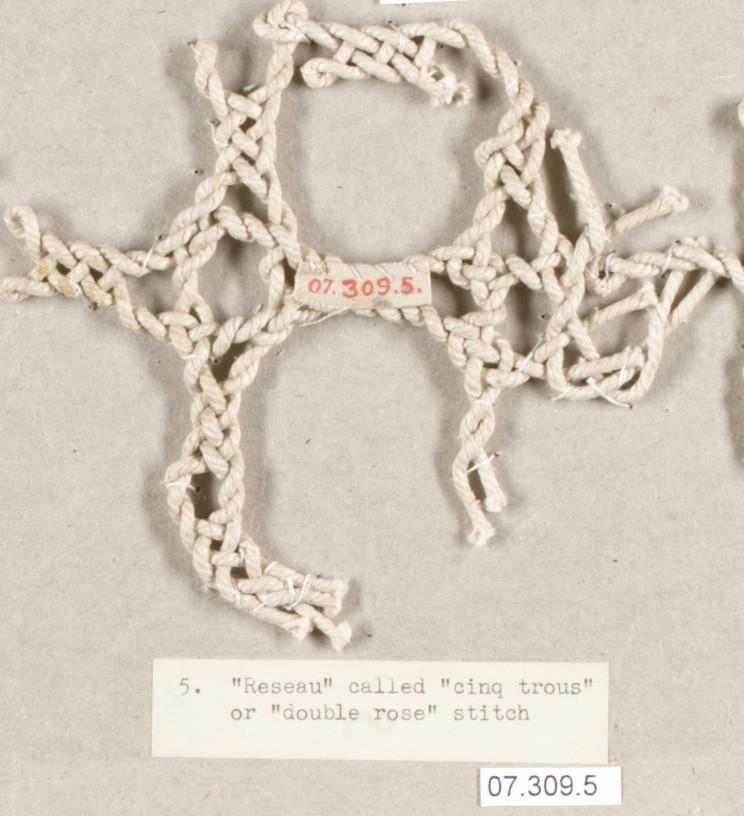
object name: stitch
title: Example of lace stitch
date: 1801-2000